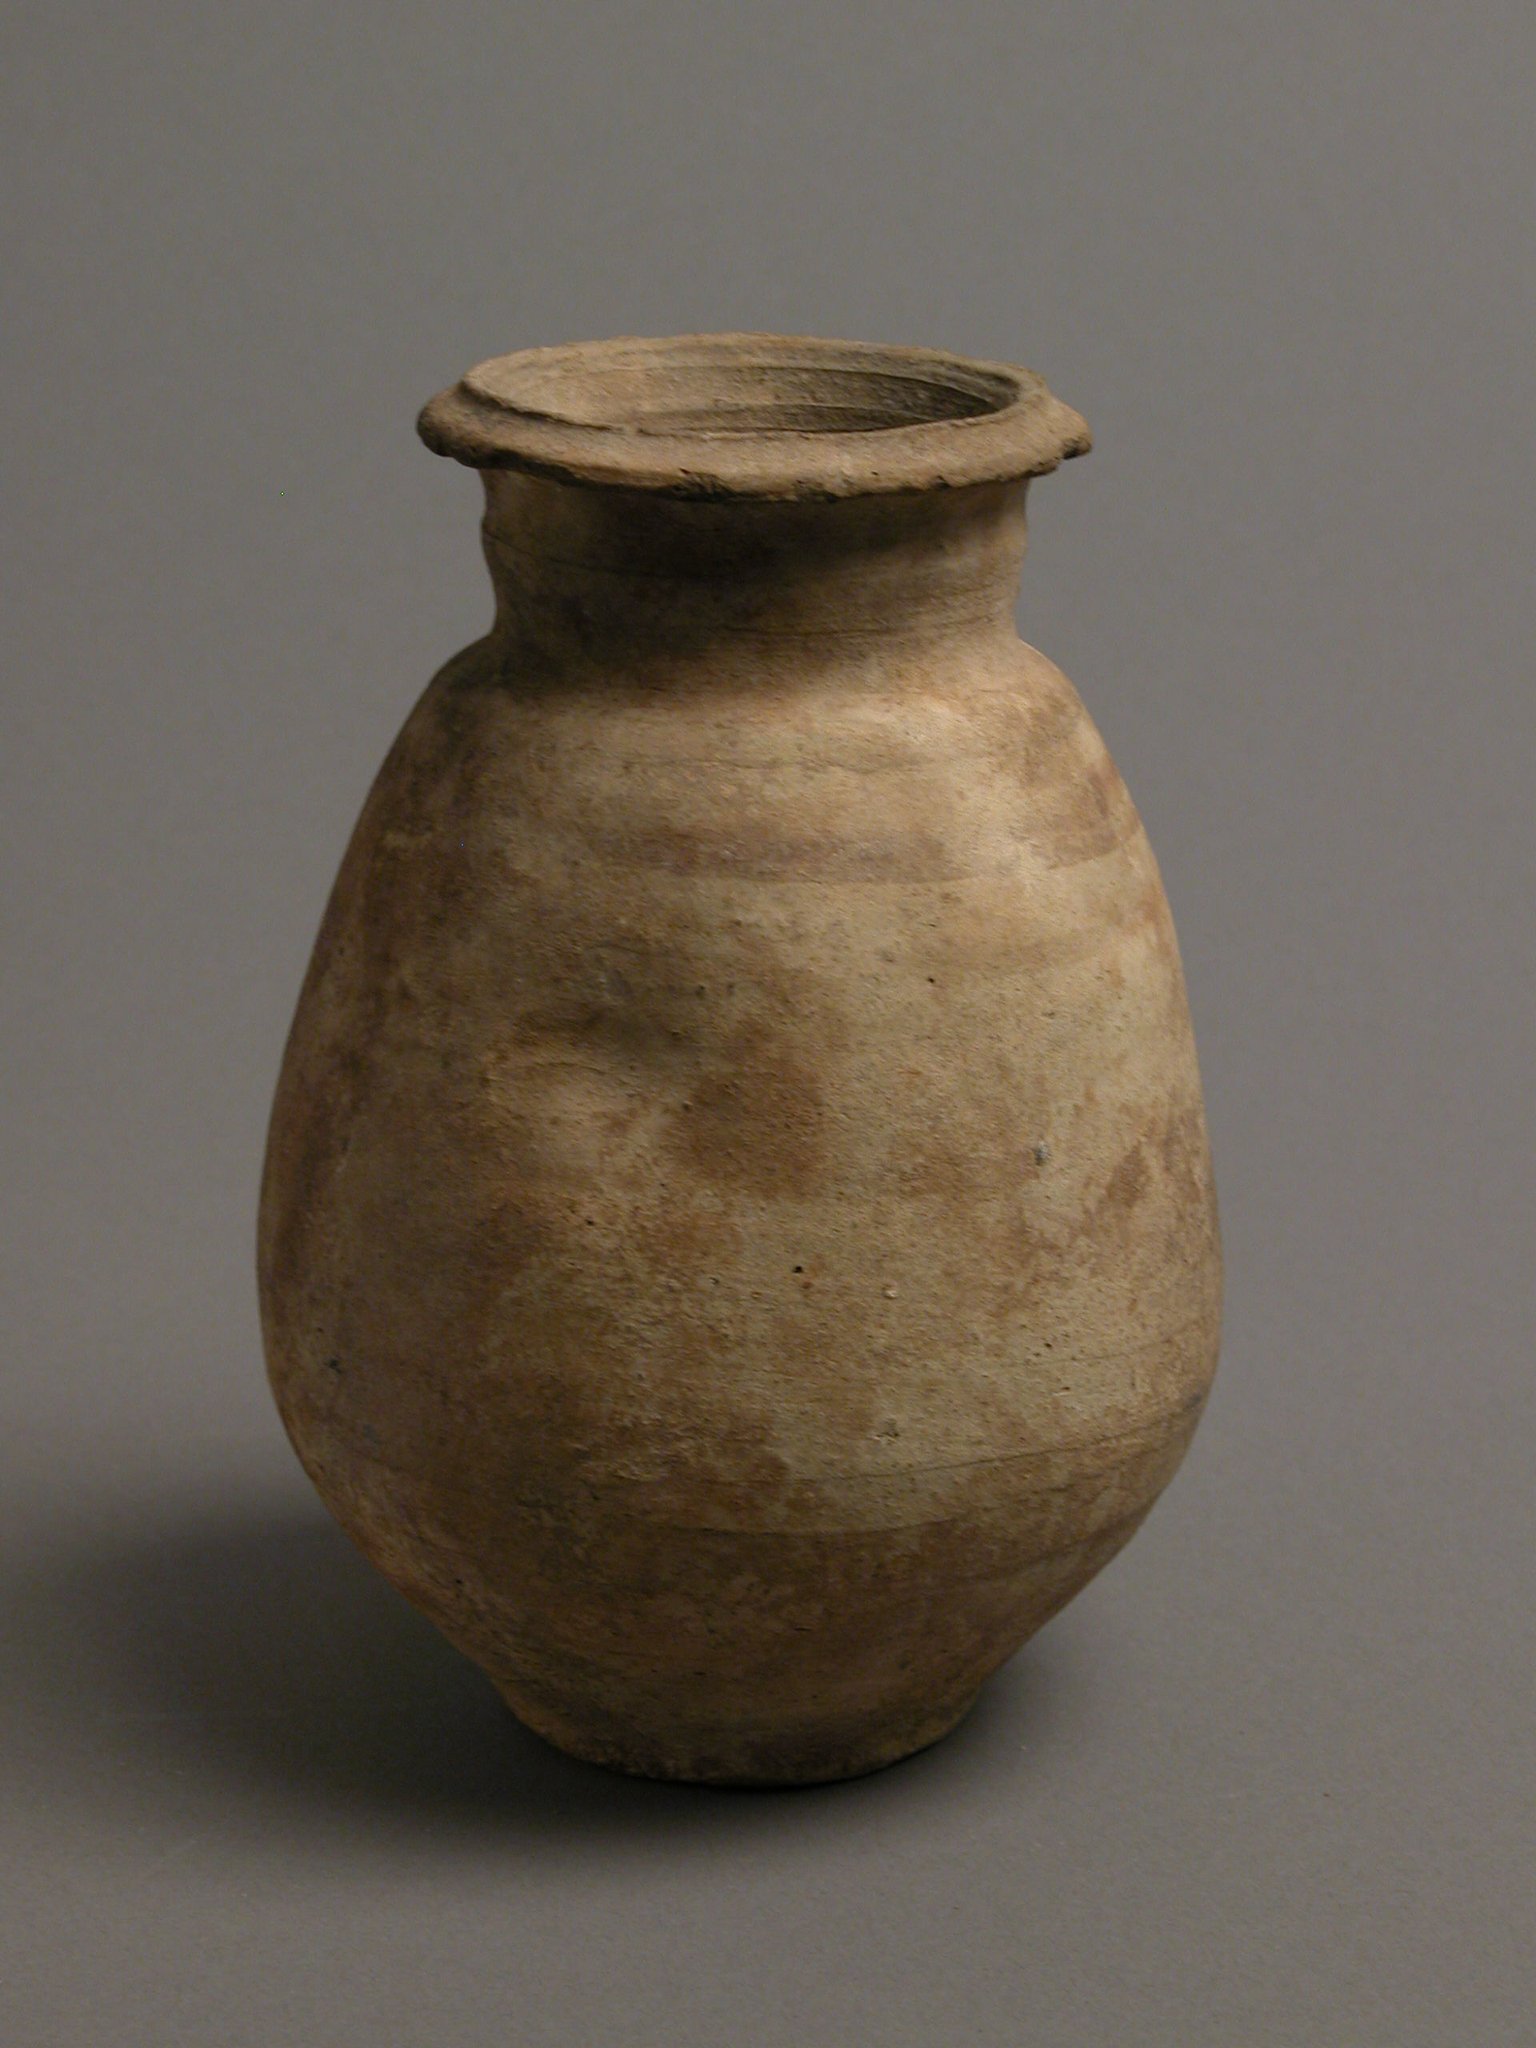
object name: vase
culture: coptic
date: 301-700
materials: earthenware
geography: egypt